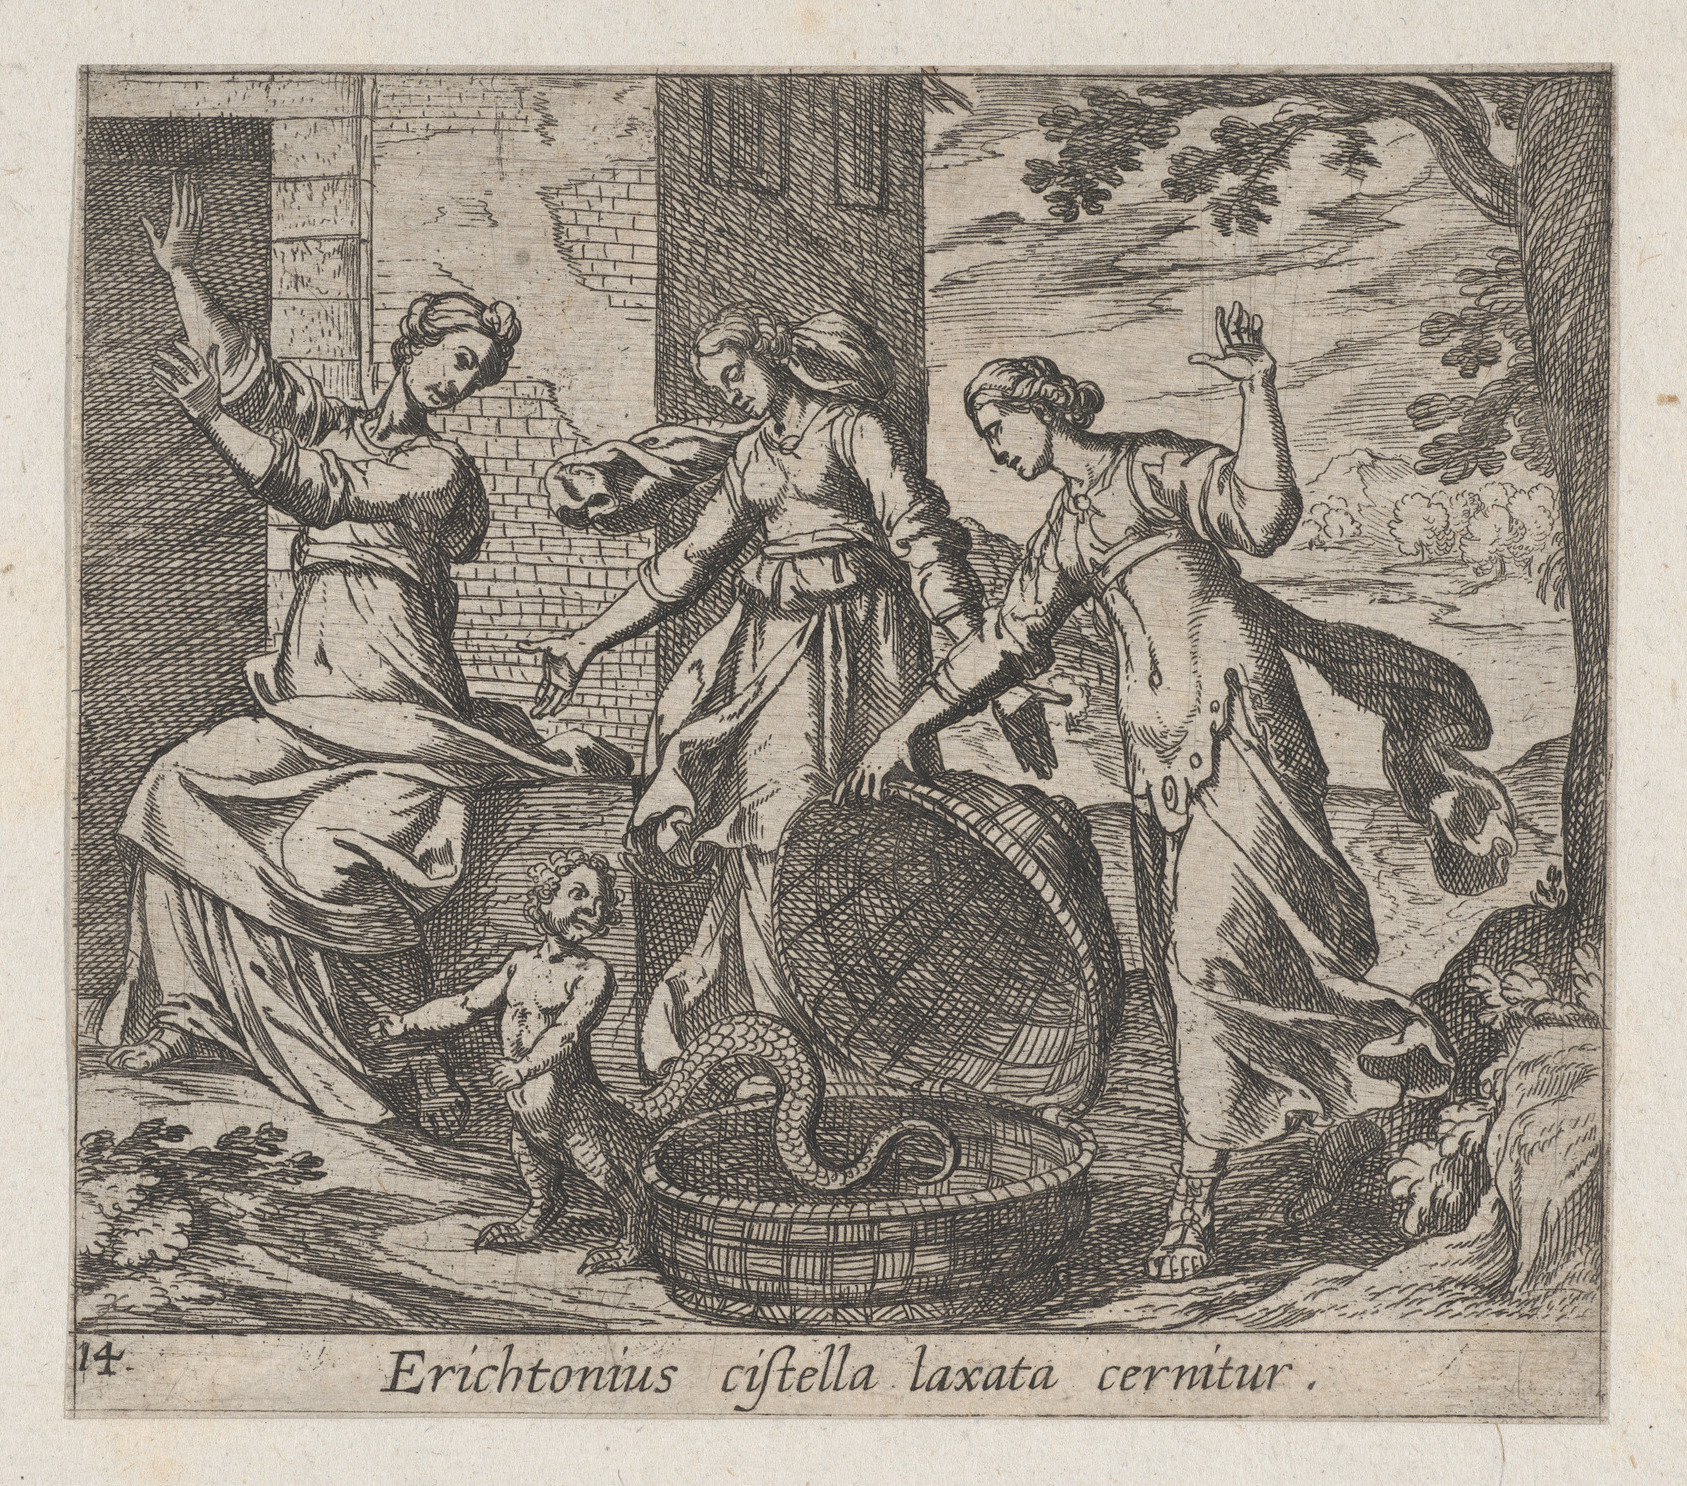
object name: print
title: Plate 14: Erichthonius Released from his Basket (Erichtonius cistella laxata cernitur), from Ovid's 'Metamorphoses'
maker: antonio tempesta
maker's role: artist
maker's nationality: italian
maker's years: 1555-1630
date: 1606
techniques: etching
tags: infants,women,serpents,baskets